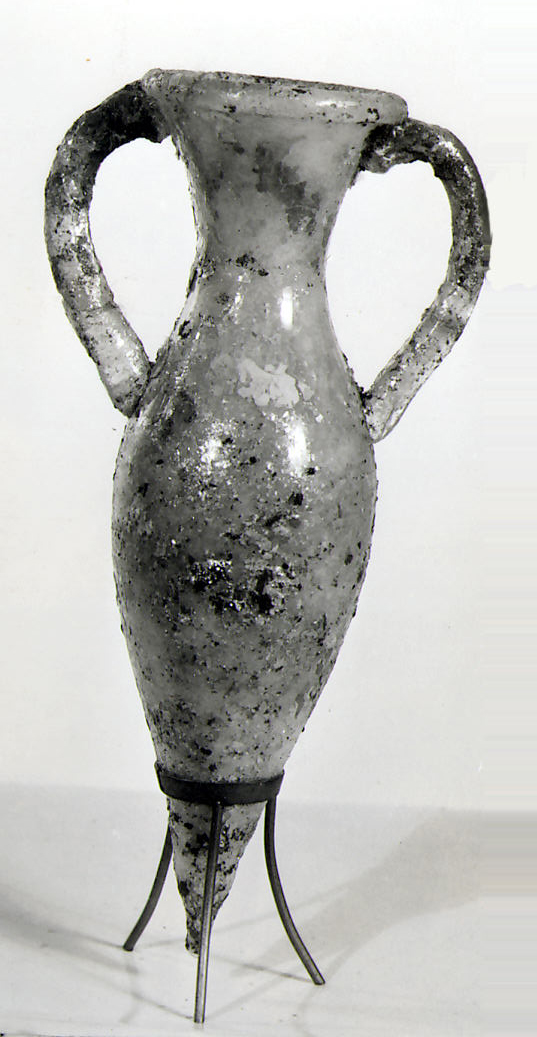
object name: vase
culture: modern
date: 7000 BCE-330 CE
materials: glass